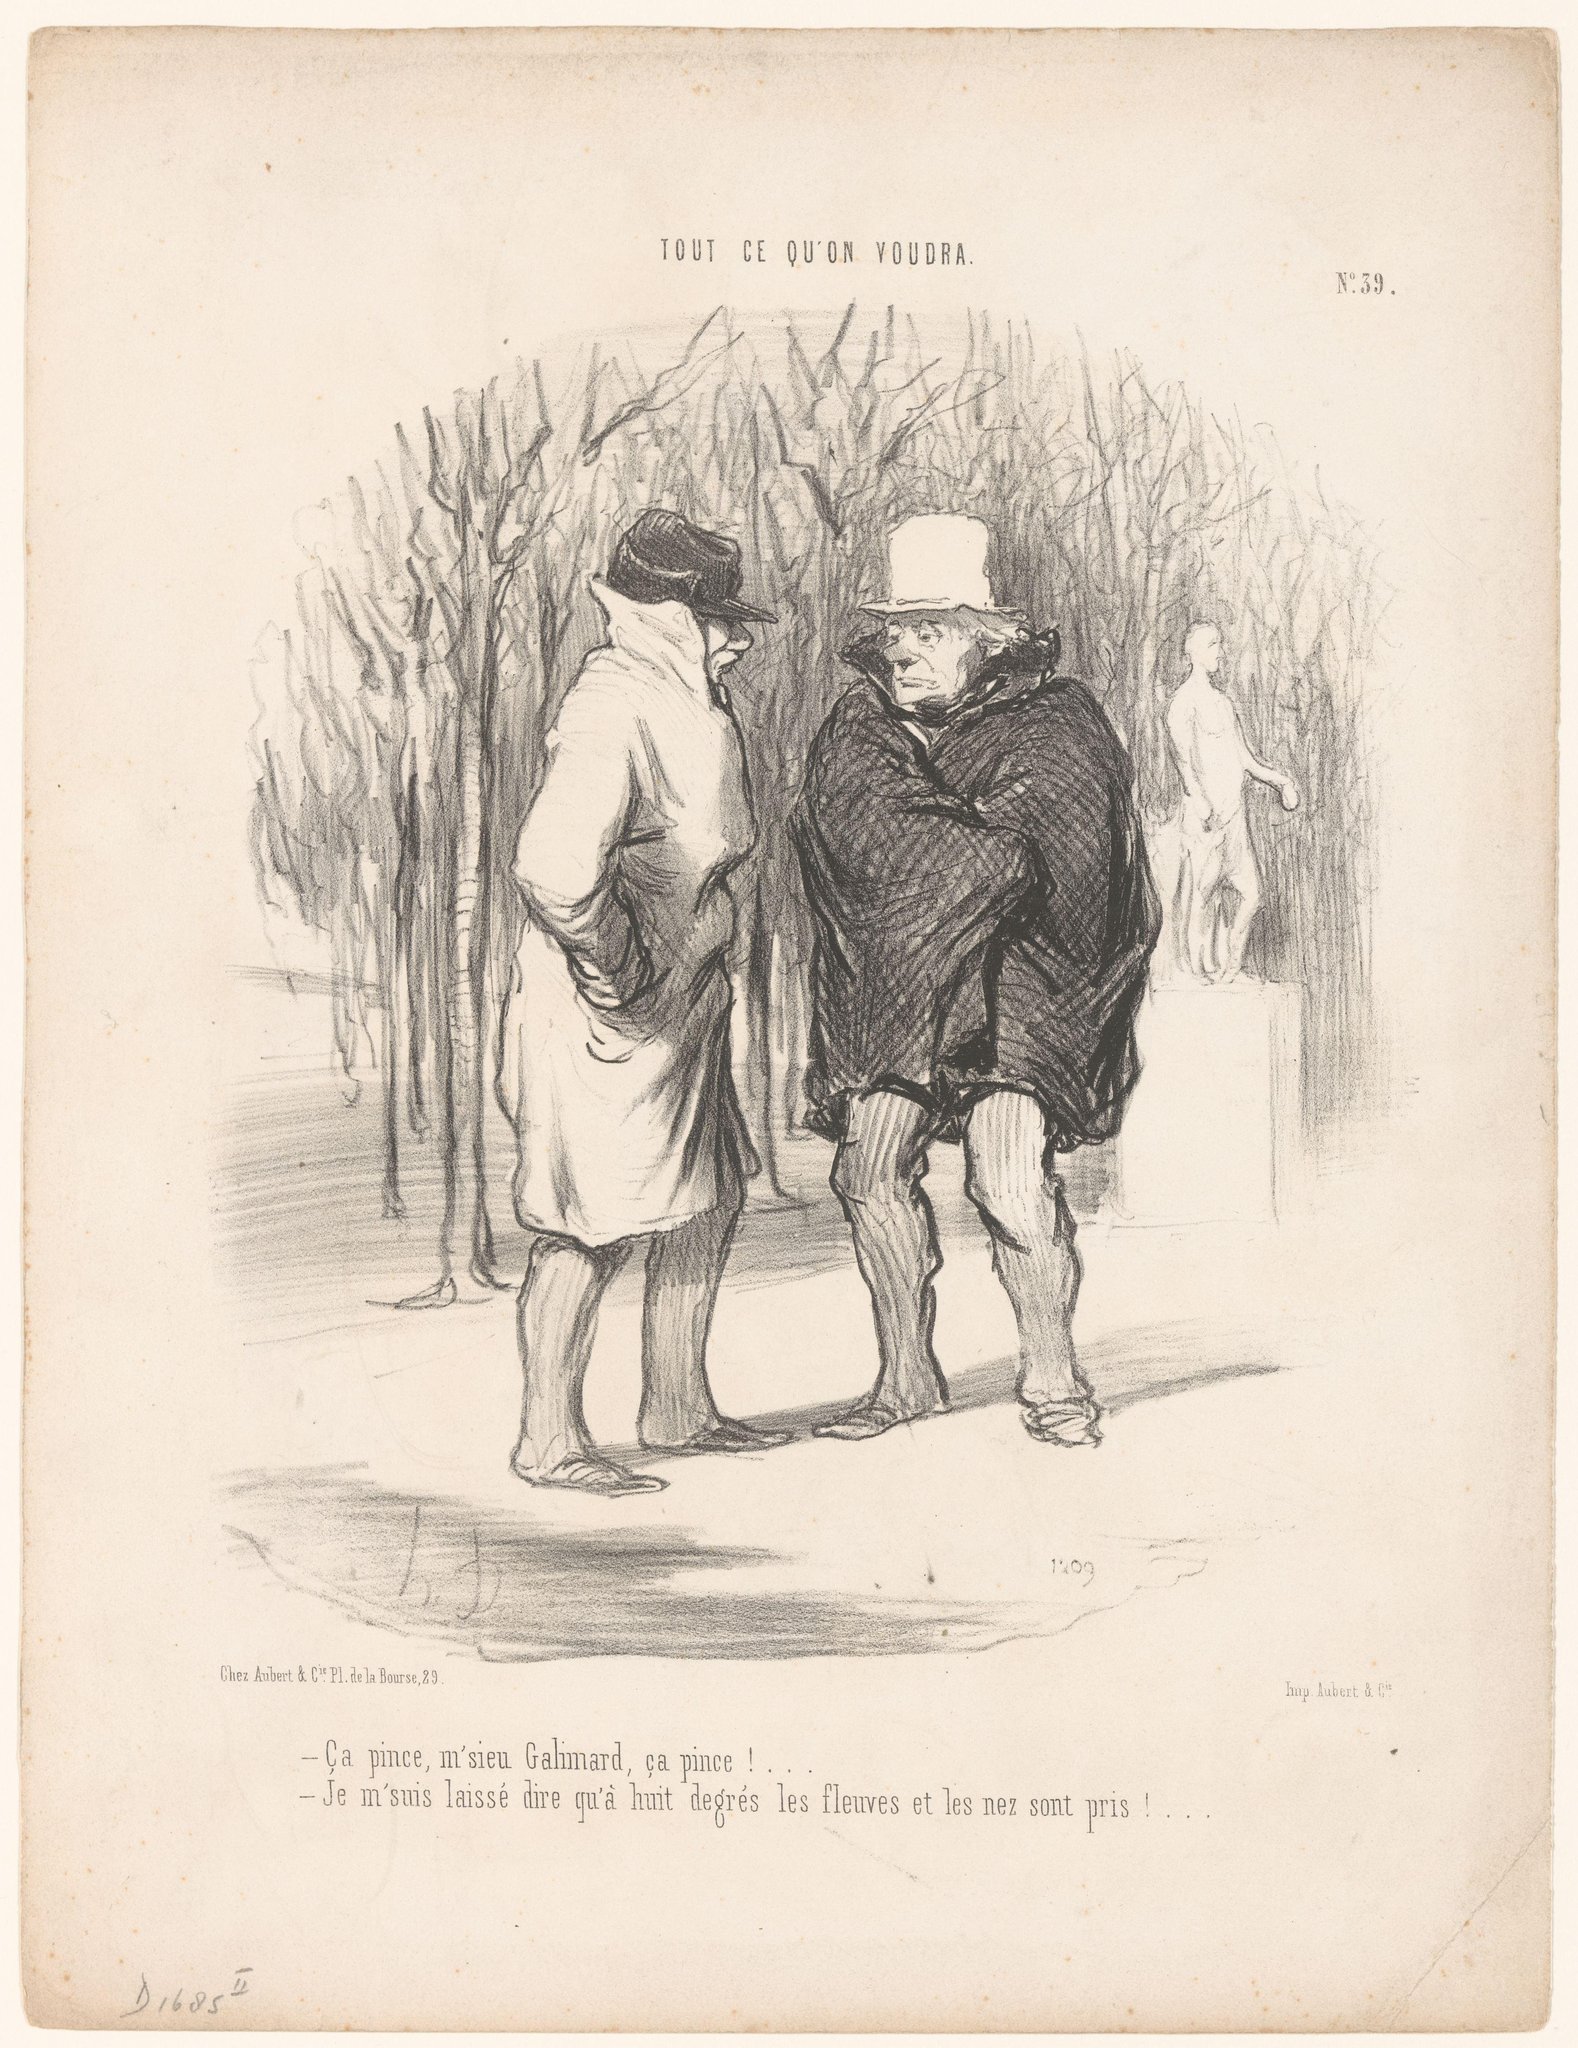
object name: cartoon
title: Ça pince, m'sieu Galimard, ça pince! (...)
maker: honoré daumier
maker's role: draughtsman, painter, print maker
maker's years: 1808-1879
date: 1848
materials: paper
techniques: lithograph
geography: paris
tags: coldness, caricatures (human types), public gardens, park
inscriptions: collector's mark: Lugt 2228a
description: Prent gebruikt voor: Le Charivari, 2 februari 1848.